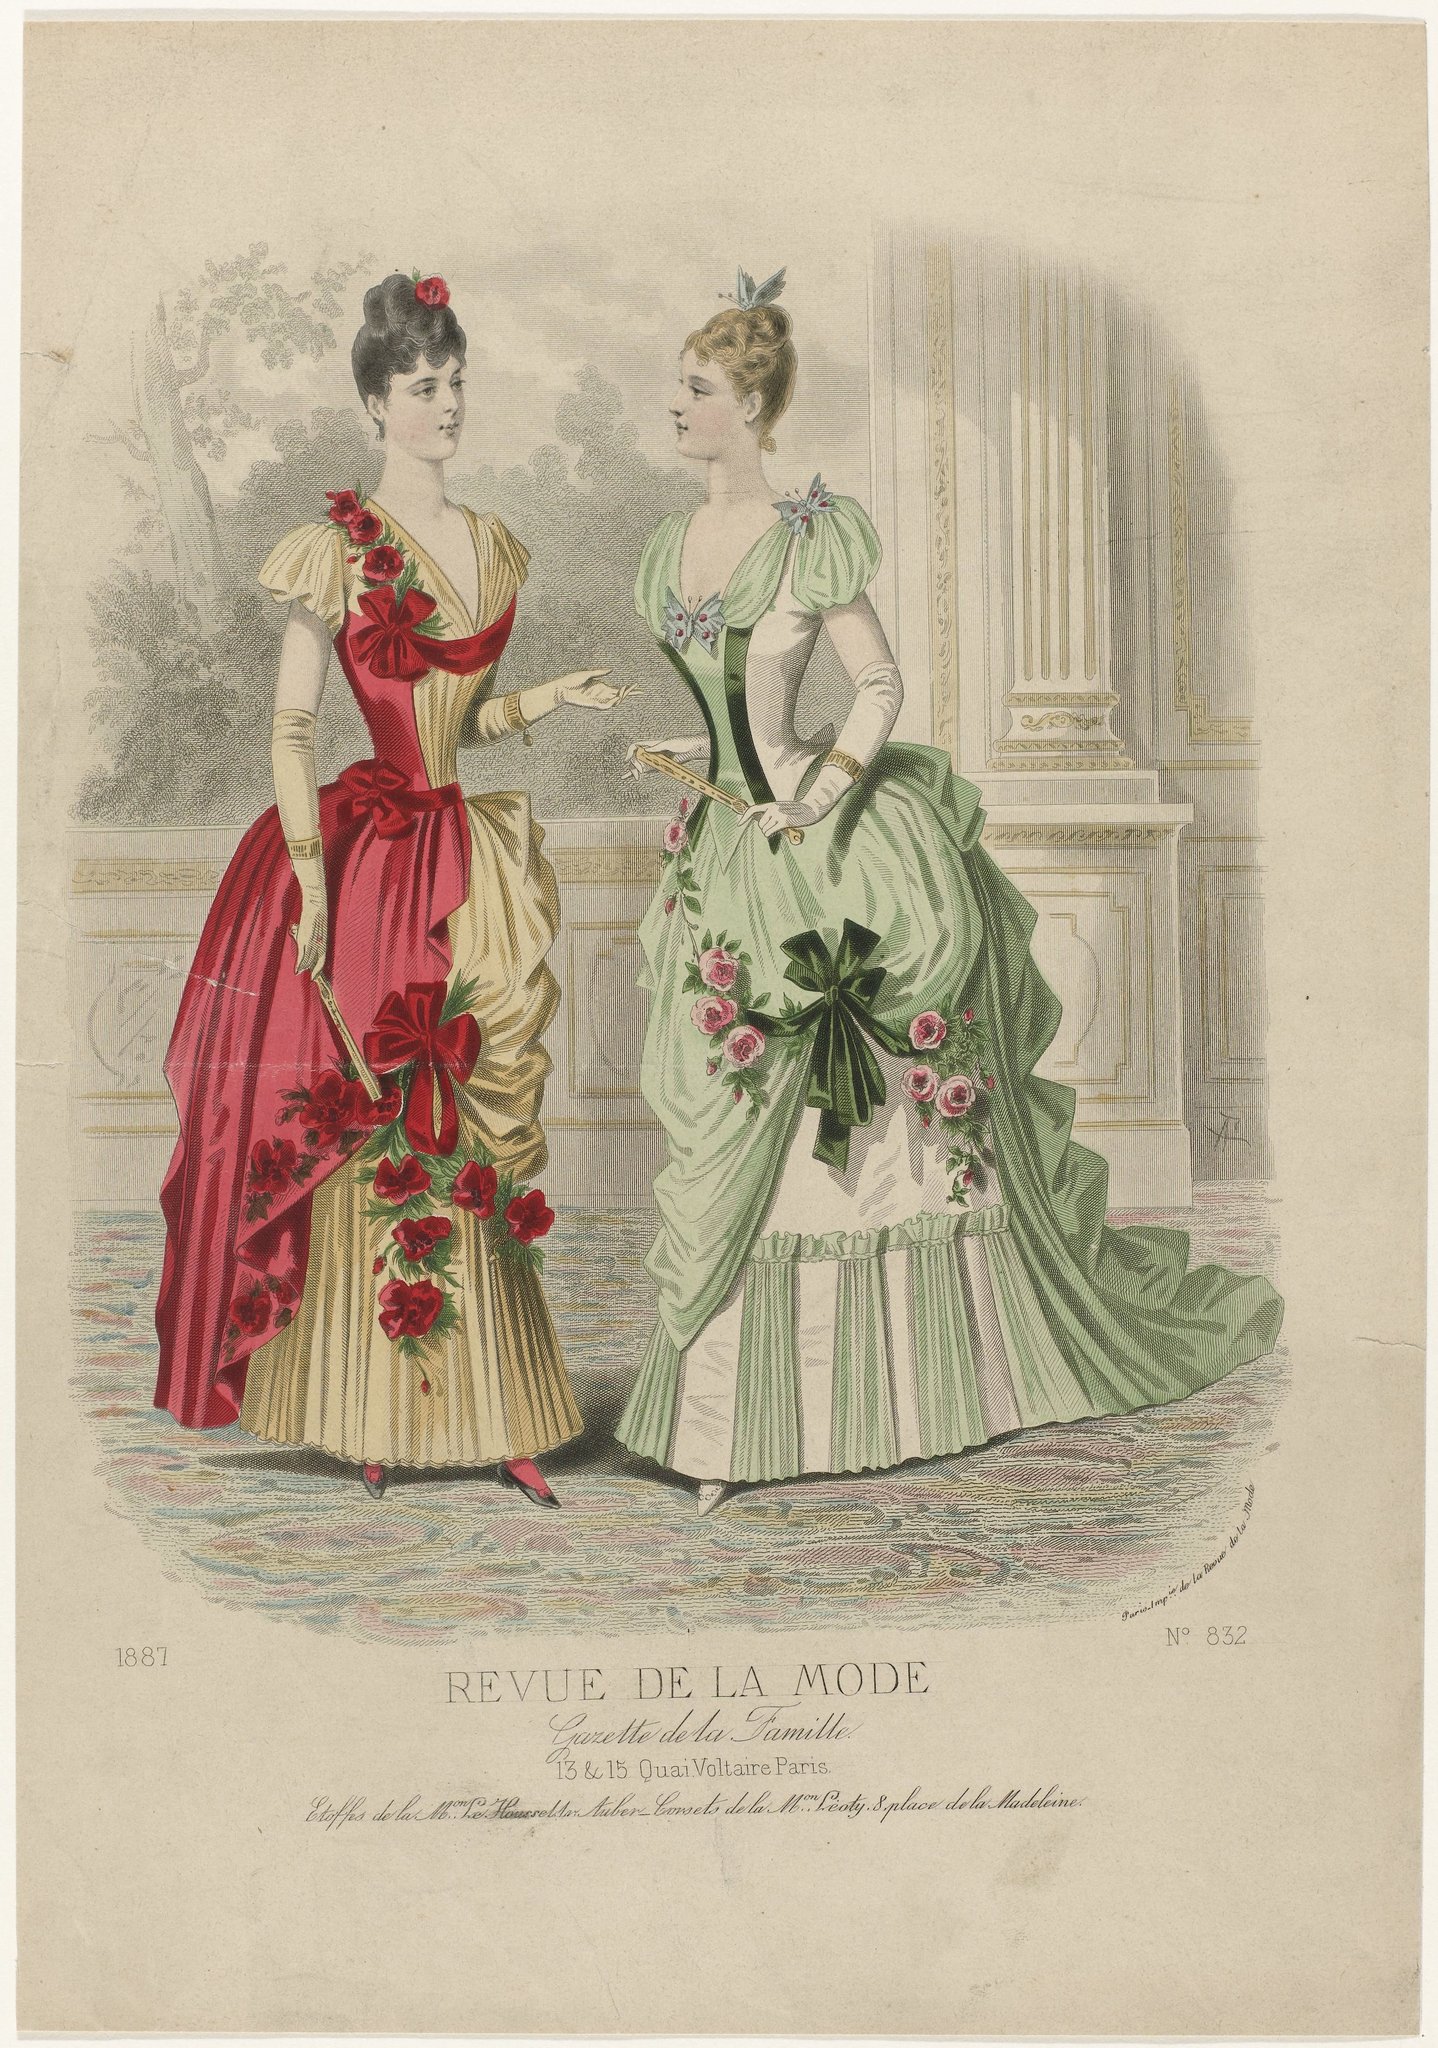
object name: fashion print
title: Revue de la Mode, Gazette de la Famille, 1887, No. 832: Etoffes de la M.on Le Houssel (...)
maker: Anonymous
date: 1887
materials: paper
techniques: engraving, hand coloring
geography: paris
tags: corsage (+ women's clothes), dress, gown: evening dress (+ women's clothes), gloves, mittens (long gloves) (+ women's clothes), border, ribbon, braid (+ women's clothes), fashion plates, fan (+ women's clothes), insects: butterfly, flowers: rose, bracelet, wristlet (+ women's clothes)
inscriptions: caption: ‘Etoffes de la M.on Le Houssel, 1, r. Auber _ Corsets de la M.on Léoty, 8, place de la Madeleine.’, address: ‘13 & 15, Quai Voltaire Paris’, title: ‘REVUE DE LA MODE / Gazette de la Famille’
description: Twee vrouwen in een interieur. Links: avondjapon in rood en geel, versierd met strikken van rood lint en bloemcorsages. Korte pofmouwen. V-vormige hals. Rechts: avondjapon in lichtgroen en wit, versierd met donkergroen lint, bloemcorsages van rozen en vlinders bij de buste en linkerschouder. In het kapsel een idem vlinder. Accessoires: lange handschoenen, waaier, armbanden. Onder de voorstelling een regel reclametekst voor verschillende producten. Prent uit het modetijdschrift Revue de la Mode (1872-1913).